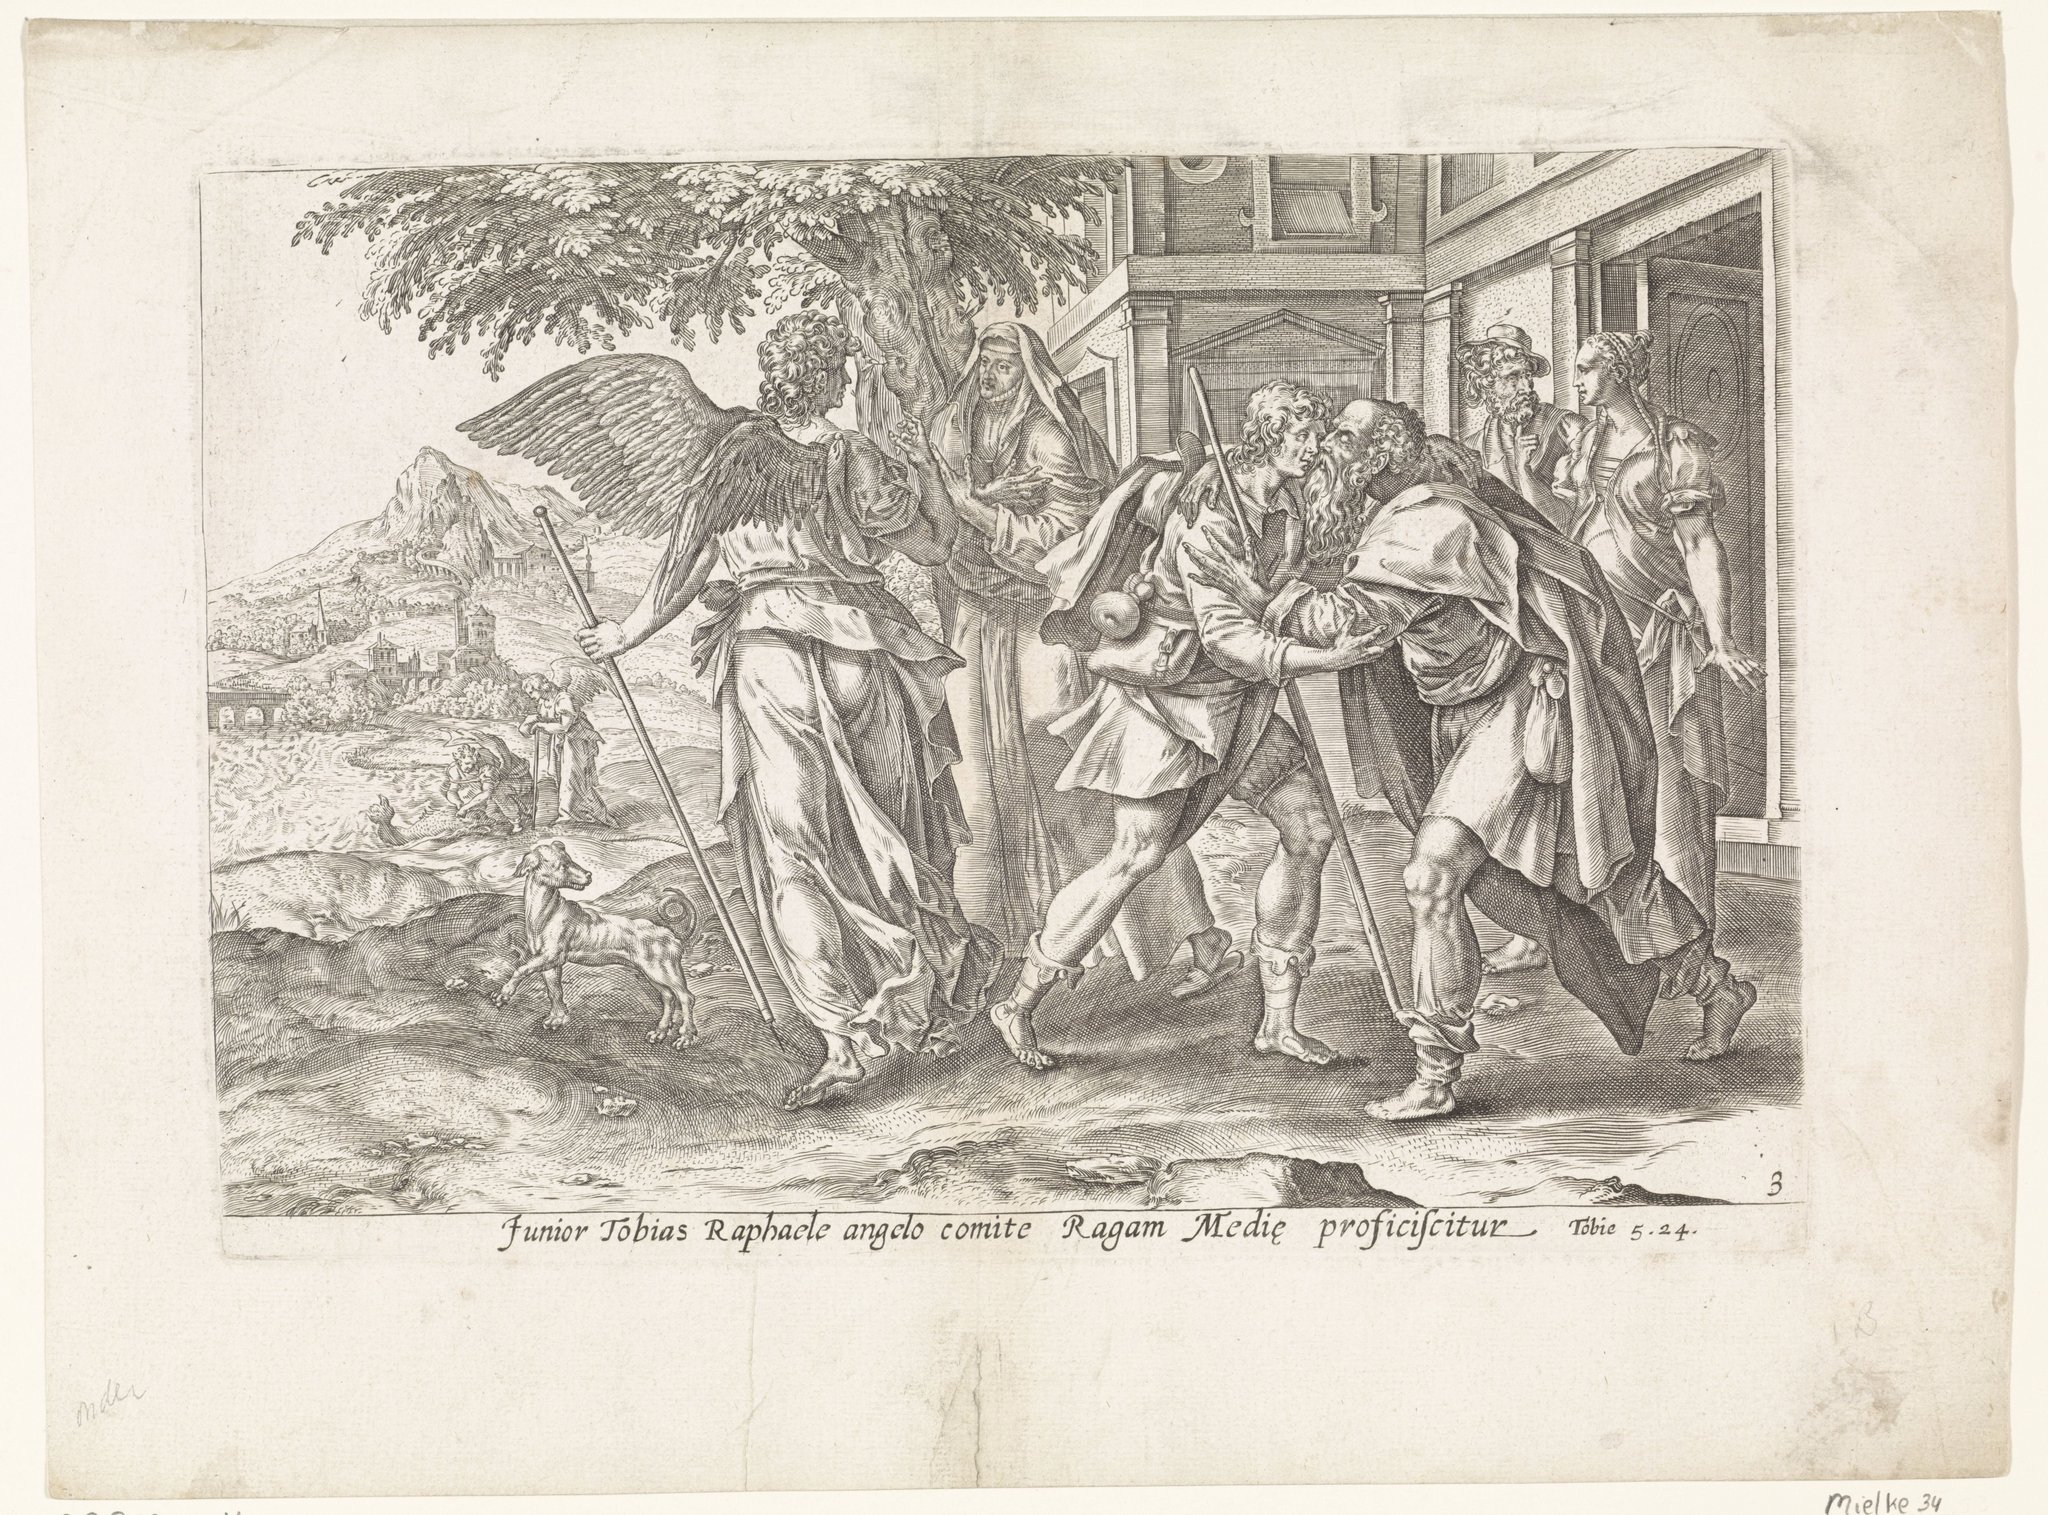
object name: print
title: Tobias en de engel nemen afscheid van Tobit en Anna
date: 1585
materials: paper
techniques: engraving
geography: amsterdam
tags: tobias taking leave of his parents; anna mourns her son's departure, the angel raphael tells tobias to cut the fish to pieces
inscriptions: collector's mark: Lugt 2228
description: Tobias en de engel Rafaël nemen afscheid van Tobias' ouders Tobit en Anna. Rechtsachter Tobias en de engel bij de rivier de Tigris waar Tobias het hart, de lever en de gal van de gevangen vis verwijderd en meeneemt. Onder de voorstelling een verwijzing in het Latijn naar de Bijbeltekst in Tobit 5:24.